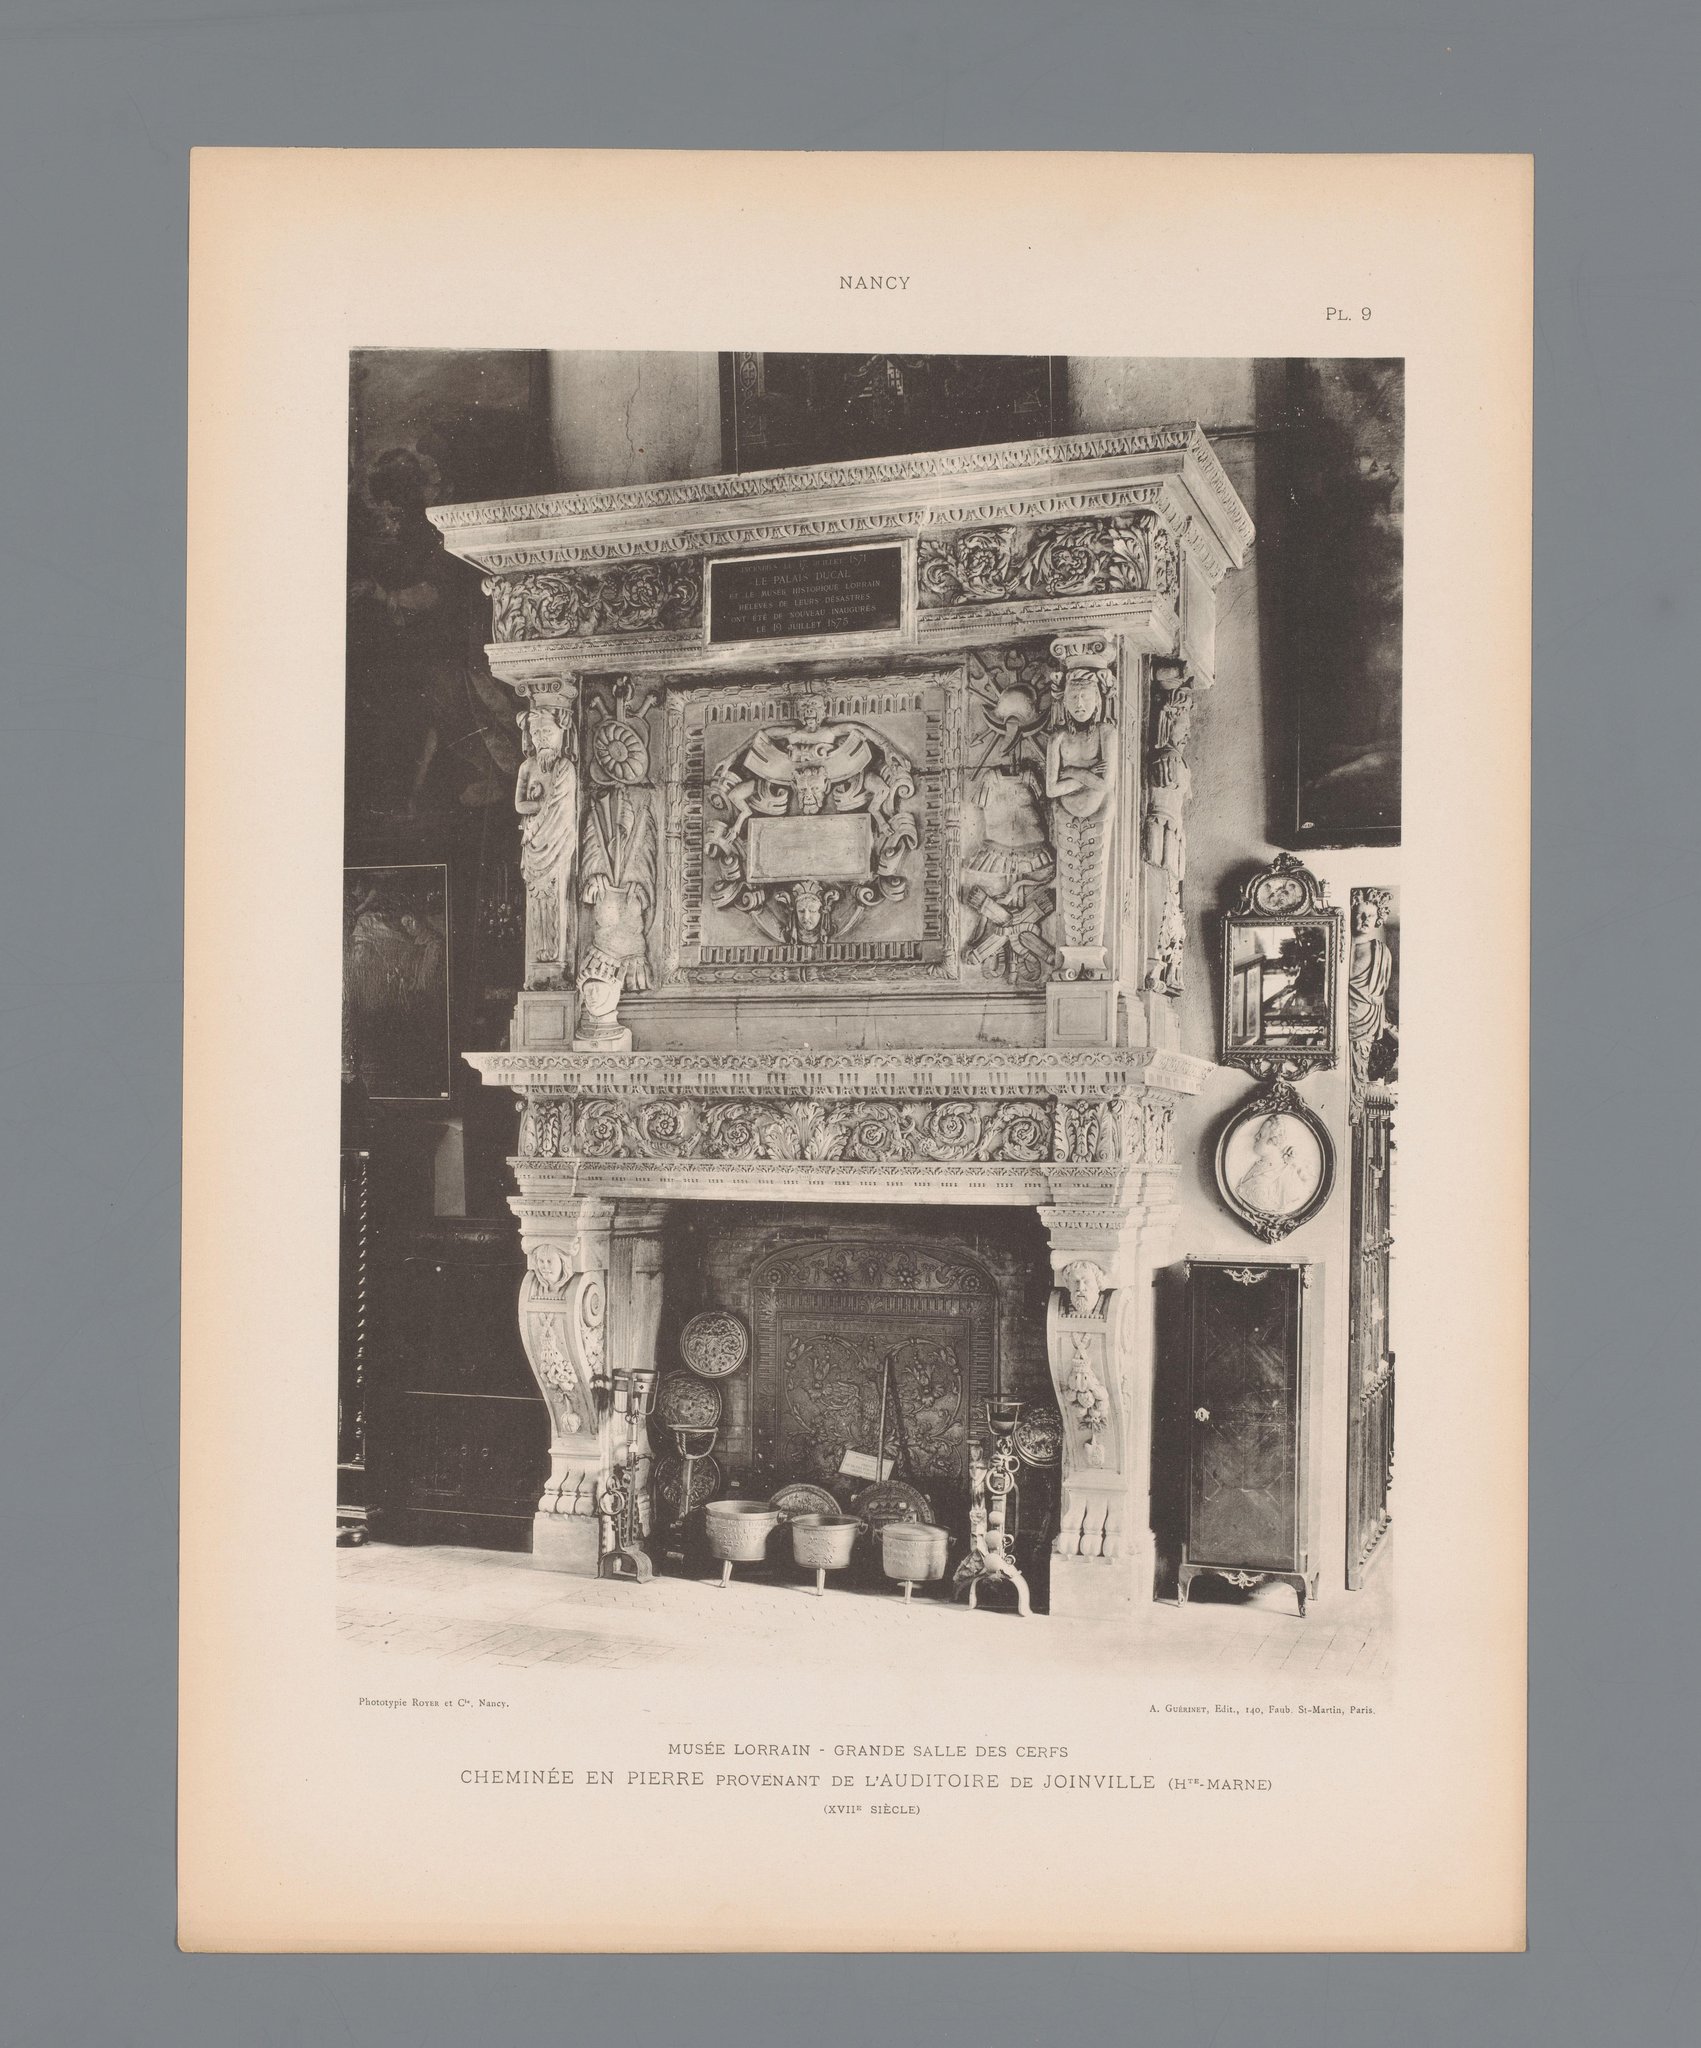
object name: photomechanical print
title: Schoorsteen in Musée Lorrain te Nancy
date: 1891-1896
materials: paper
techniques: photograph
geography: paris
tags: art collection, art gallery, chimney-piece, mantelpiece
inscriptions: inscription: ‘Cheminée en pierre provenant de l'auditoire de joinville (...)’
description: Deze prent maakt deel uit van een omslag met 103 prenten op 101 bladen en een titelblad.